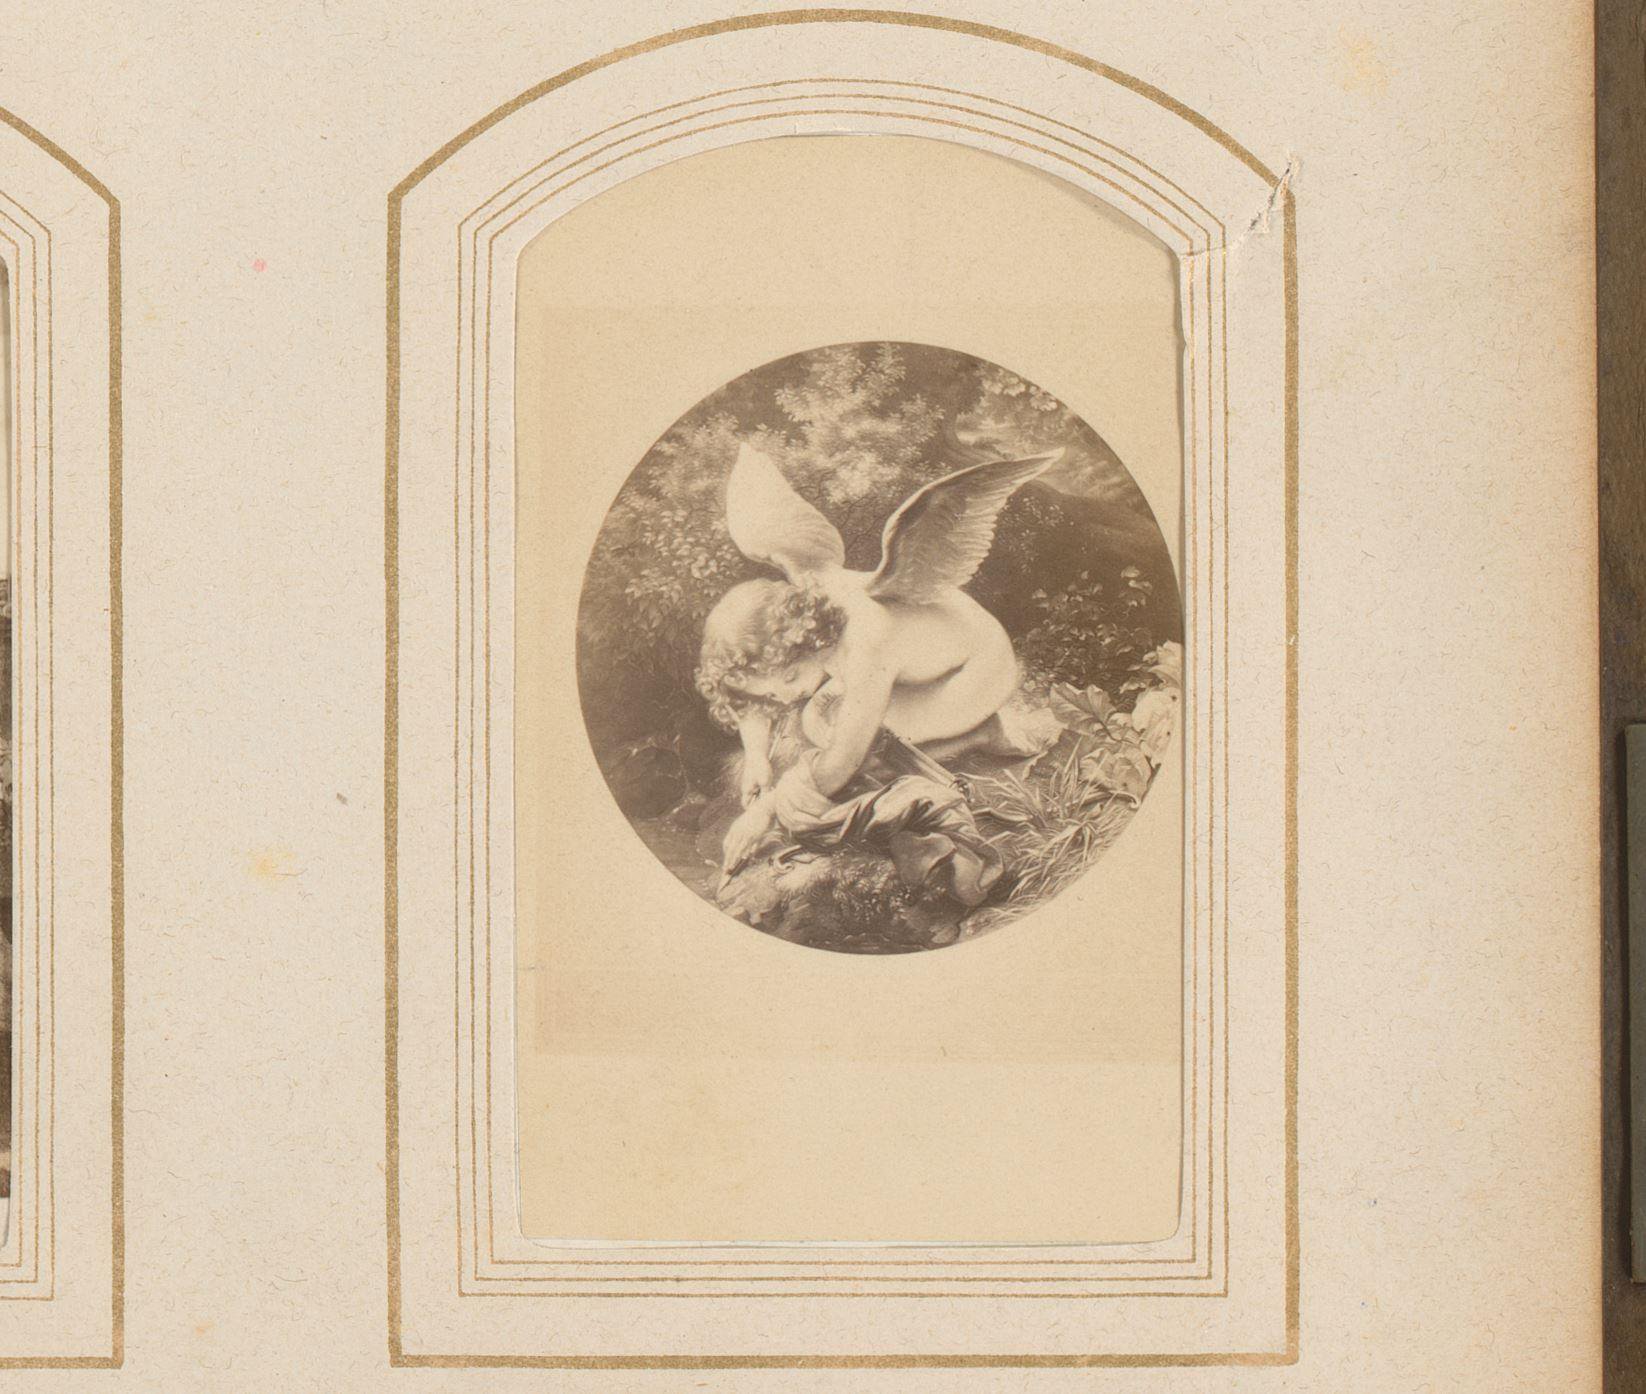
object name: album leaf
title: Fotoreproductie van Amor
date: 1870-1890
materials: cardboard, photographic support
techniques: albumen print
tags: angel(s) represented as child(ren), painting, drawing and the graphic arts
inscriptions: number: ‘2916’